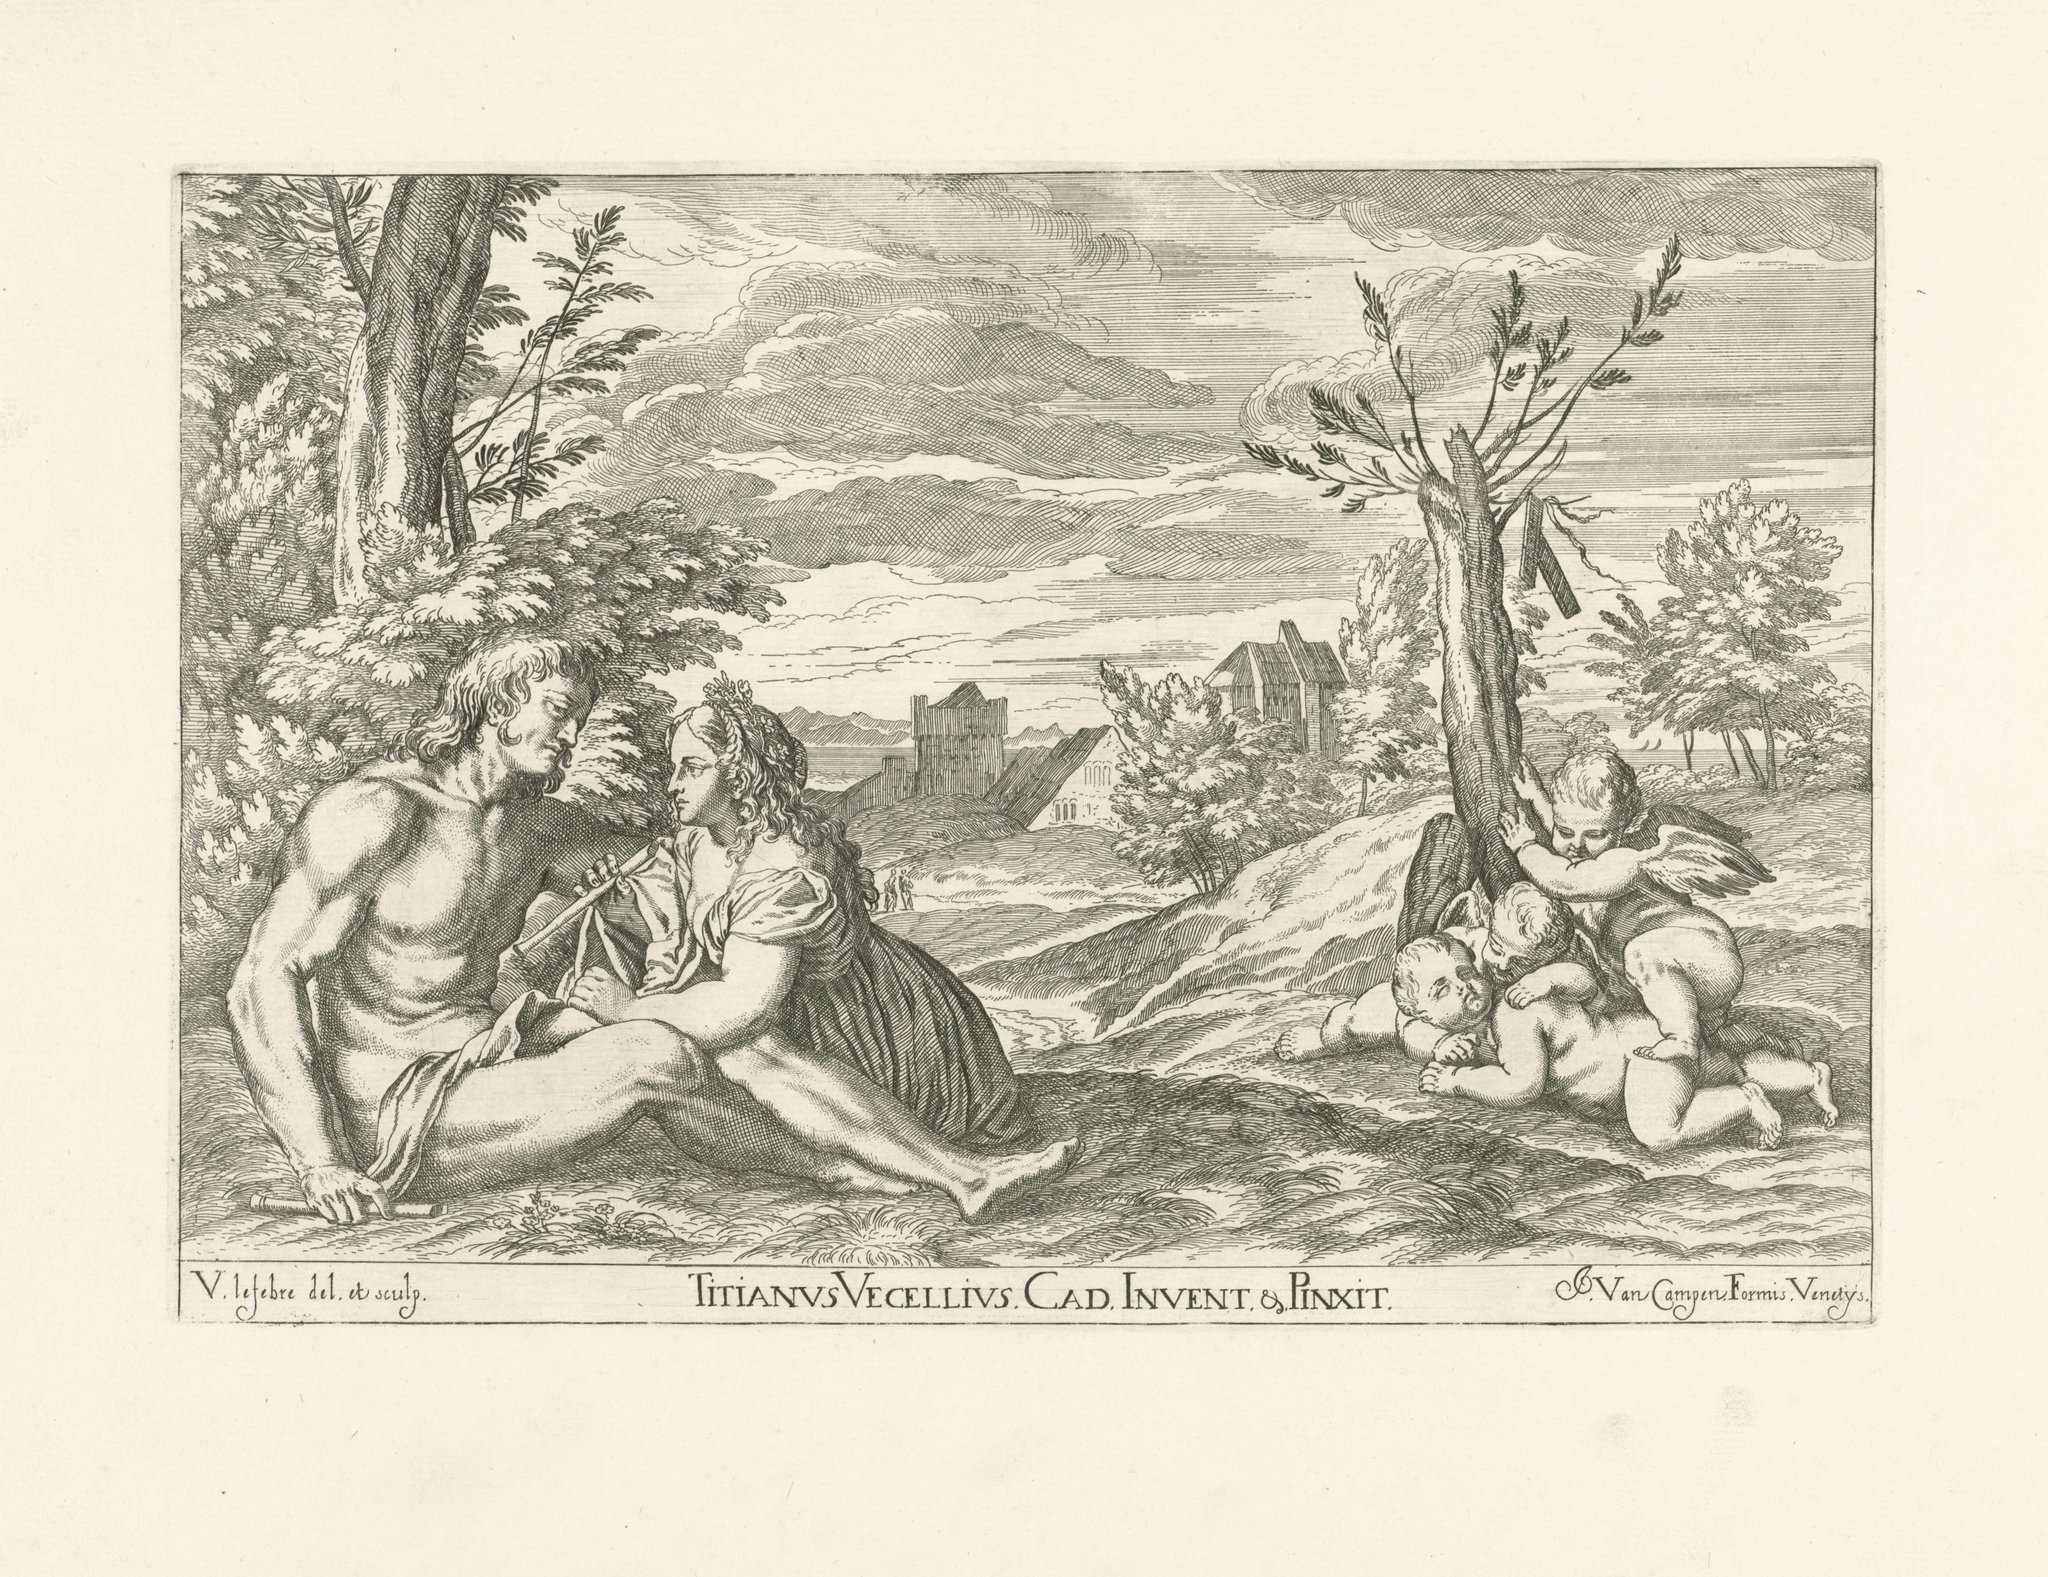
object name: print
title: Liefdespaar in een landschap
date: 1682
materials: paper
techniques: etching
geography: venice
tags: flute, aulos, tibia - cc - out of doors, couple of lovers, cupids: 'amores', 'amoretti', 'putti', landscapes - hh - ideal landscapes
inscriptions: collector's mark: Lugt 2228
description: Een liefdespaar in een landschap, beiden hebben een fluit in hun handen. Rechts spelen drie putti bij een boomstronk. De prent maakt deel uit van een 53-delige serie prenten naar schilderijen van Titiaan en Veronese.